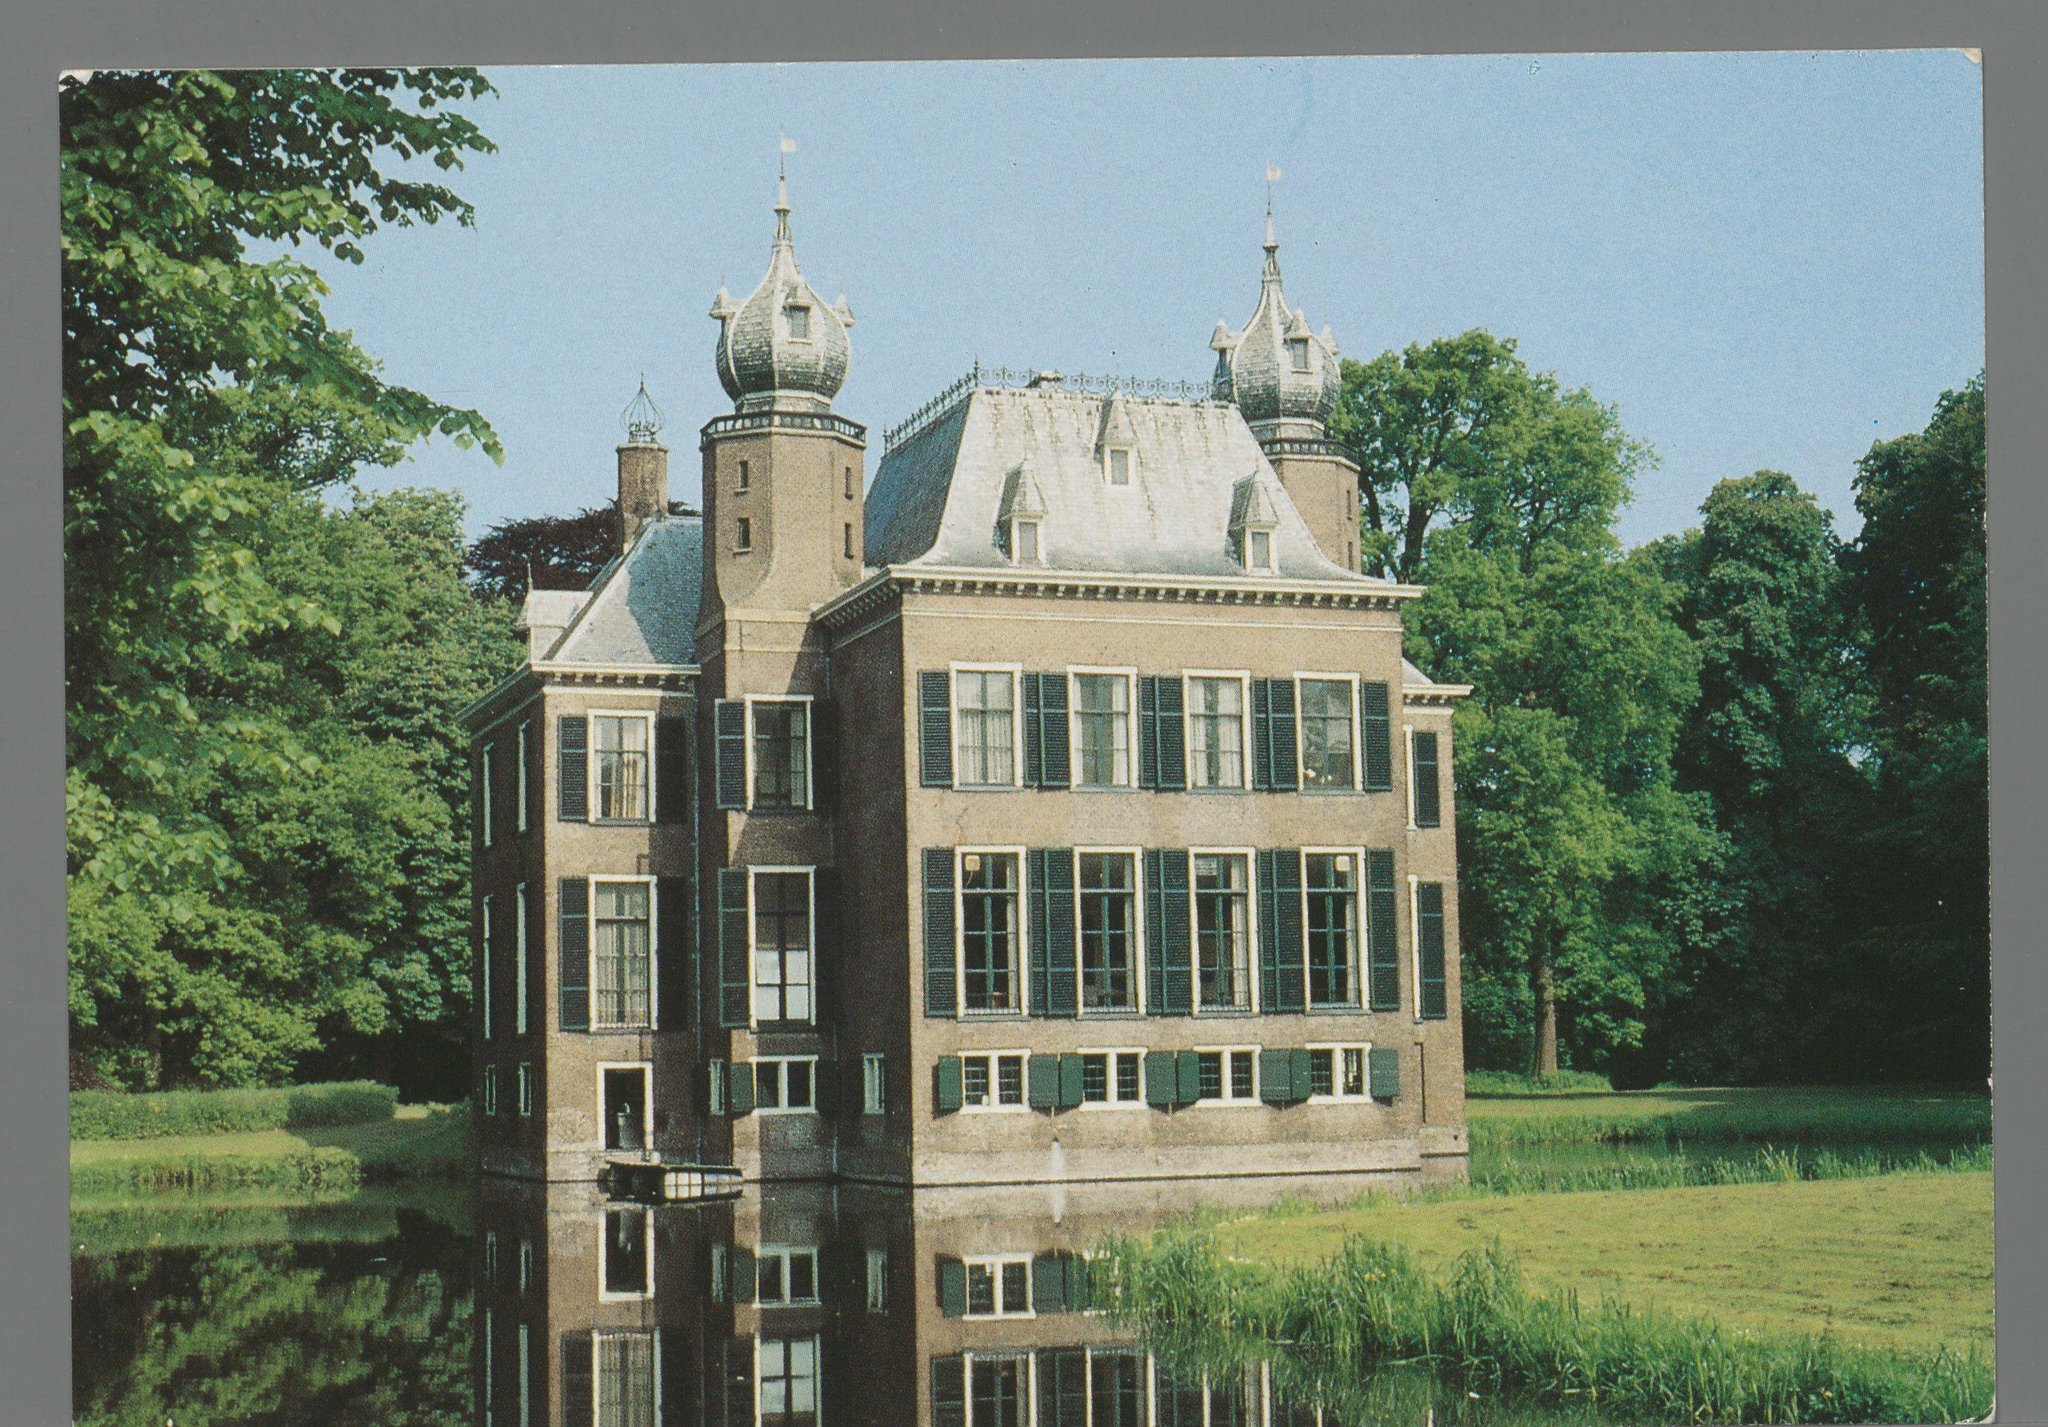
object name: ansichtkaart, prentbriefkaart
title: Oegstgeest. Kasteel Oud-Poelgeest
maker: Anonymous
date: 1985-2020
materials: cardboard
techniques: offset printed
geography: oegstgeest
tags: castle, canal